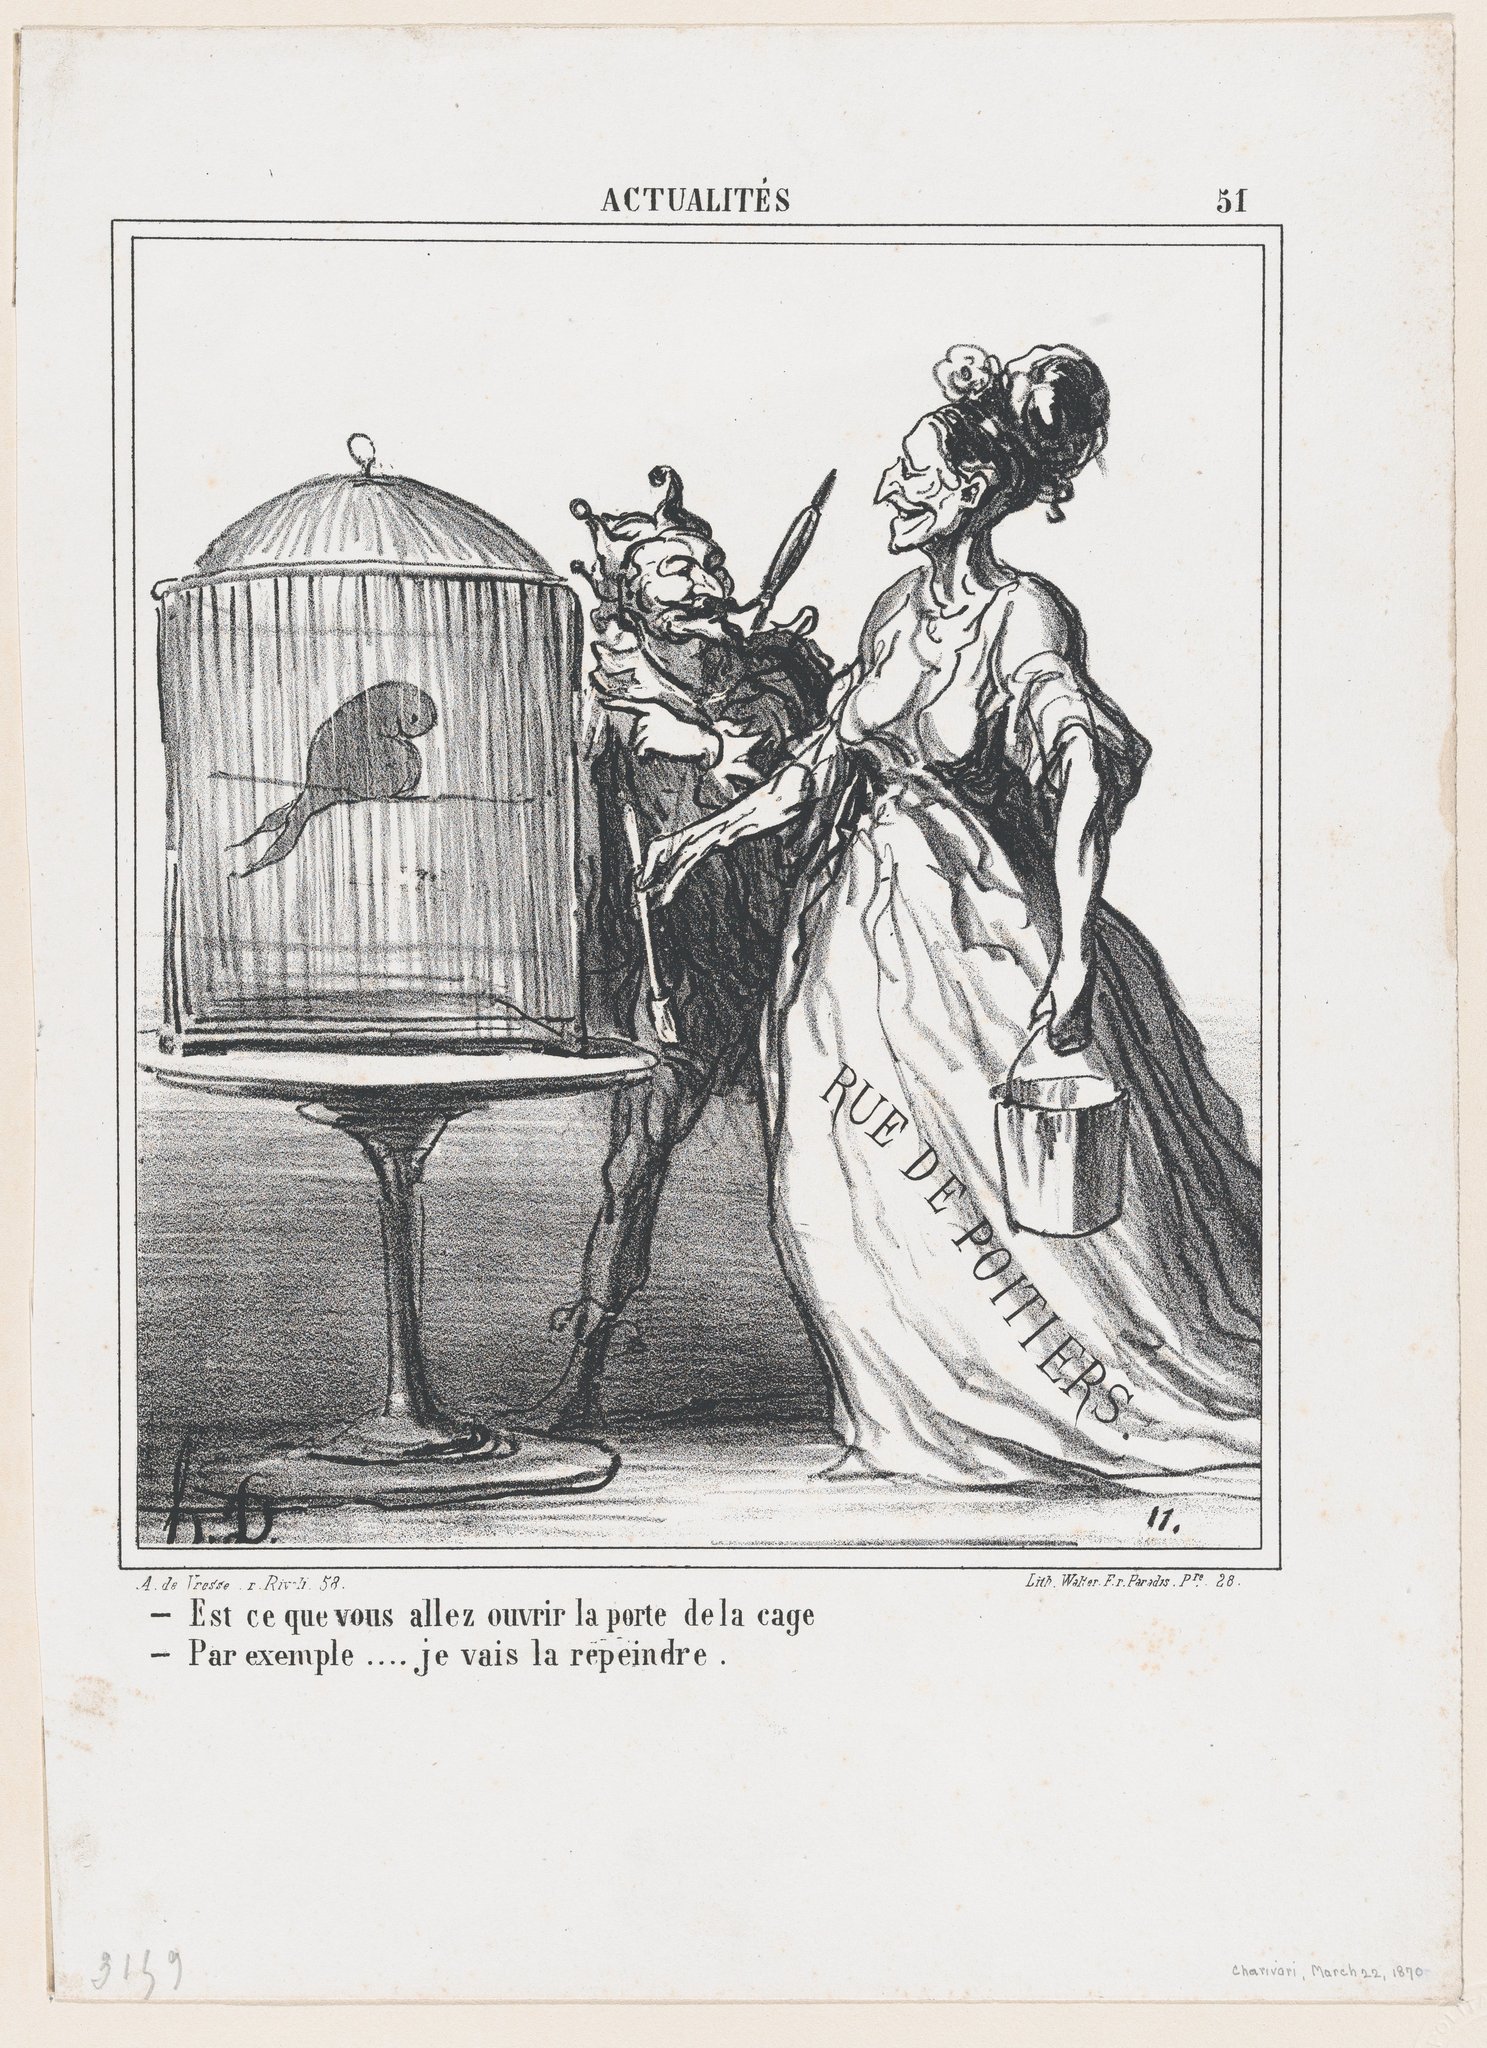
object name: print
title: –Are you going to open the door of the cage? –Indeed.... I am going to repaint it, from 'News of the day,' published in "Le Charivari"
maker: honoré daumier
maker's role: artist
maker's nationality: french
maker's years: 1808-1879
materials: paper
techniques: lithograph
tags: birds,men,women